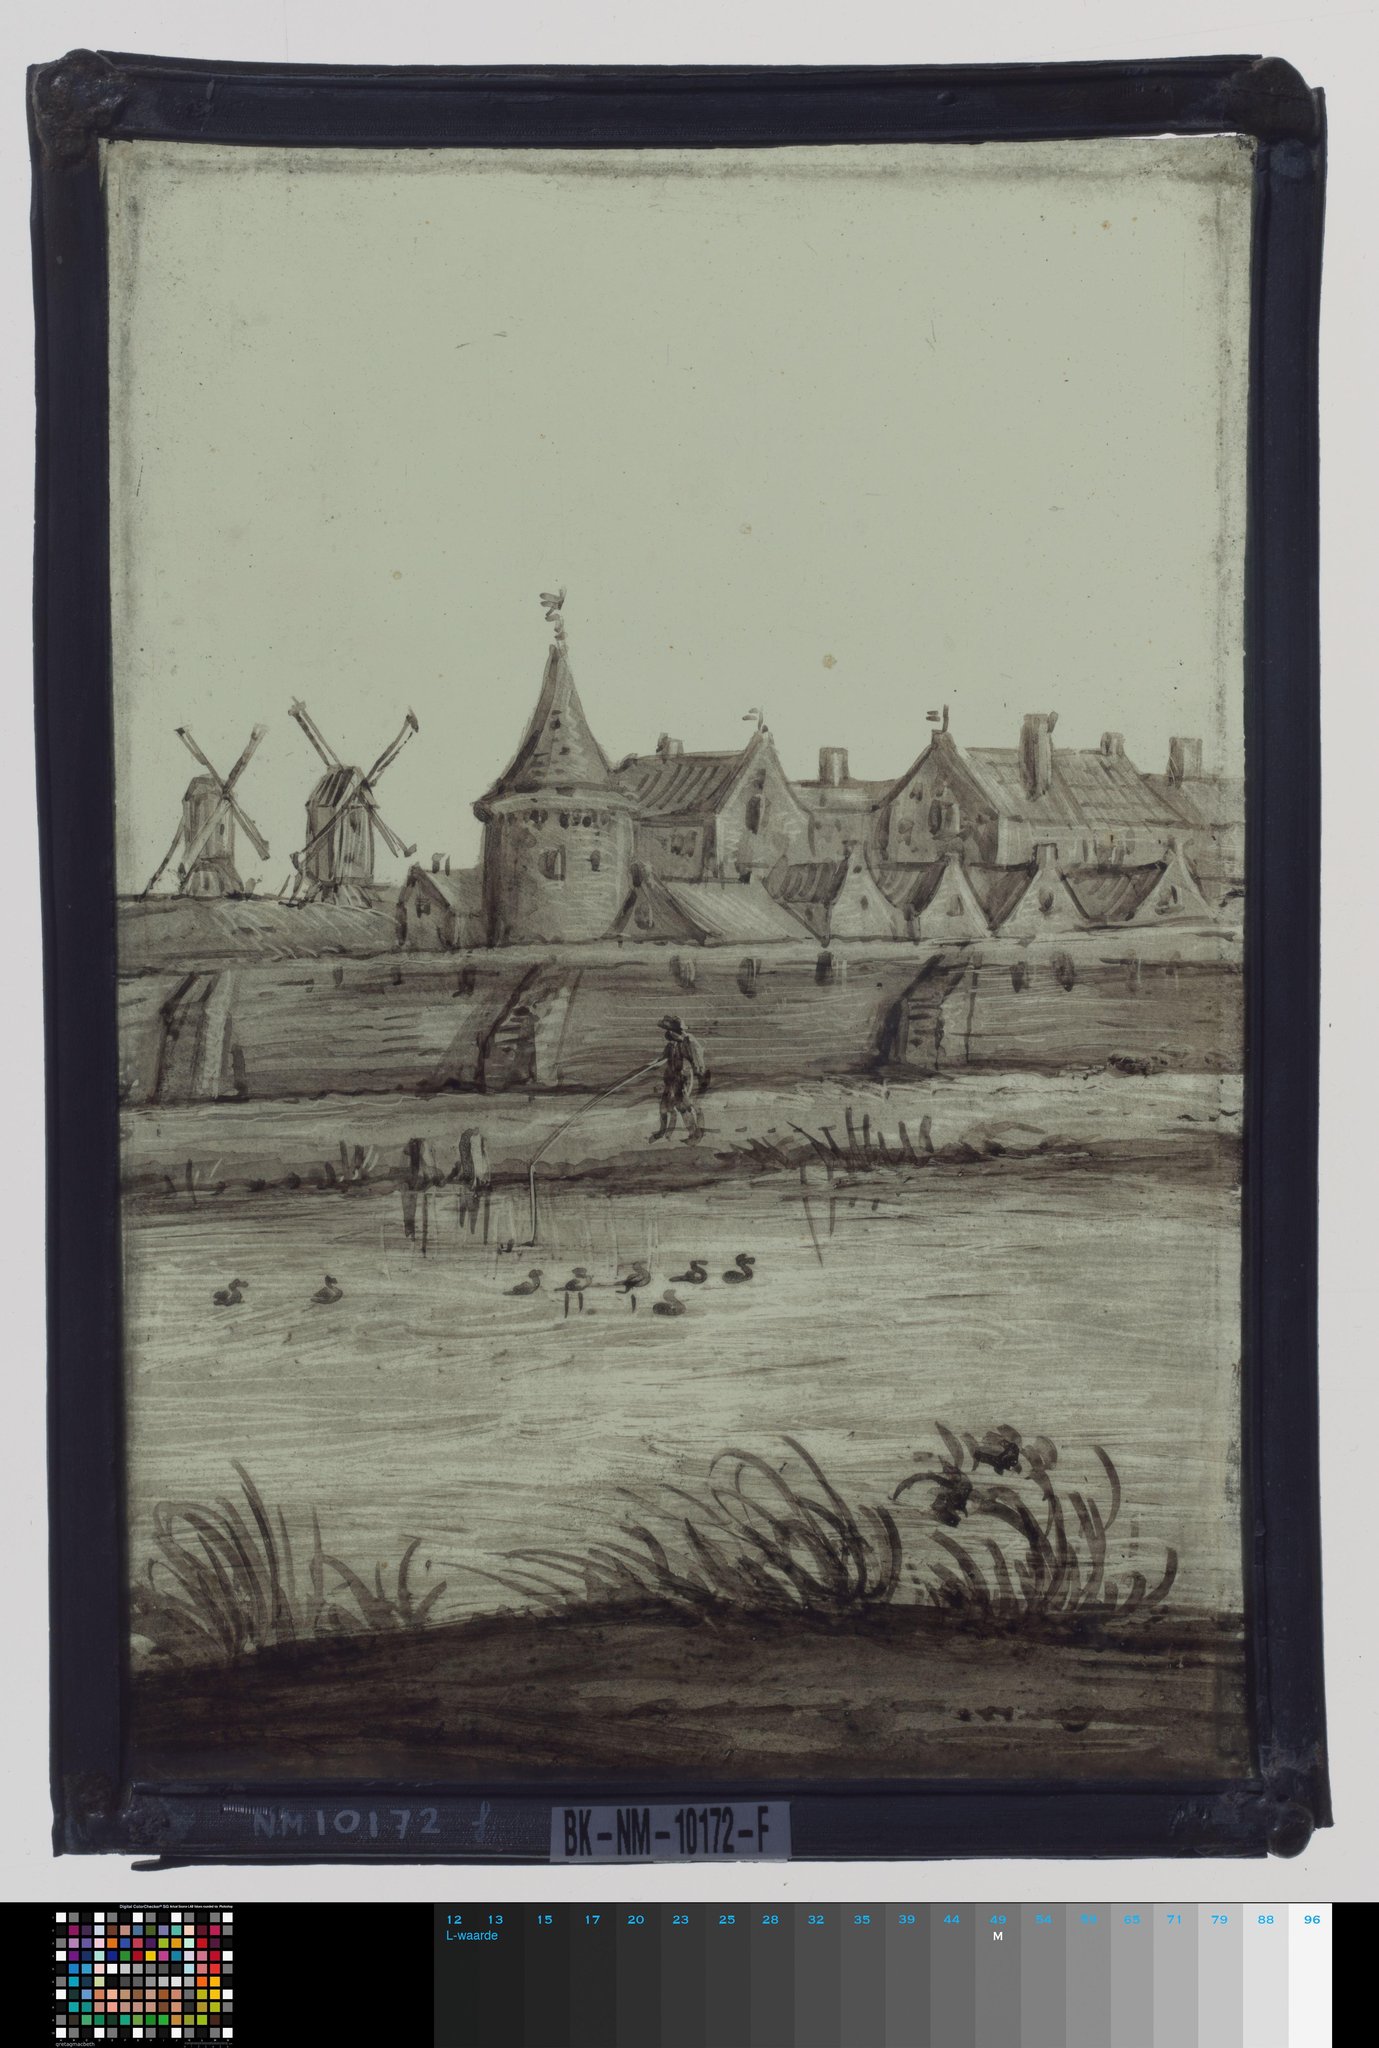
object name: light window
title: Ruit met een gezicht op een stadswal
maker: Anonymous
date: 1600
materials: glass, lead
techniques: leading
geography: northern netherlands